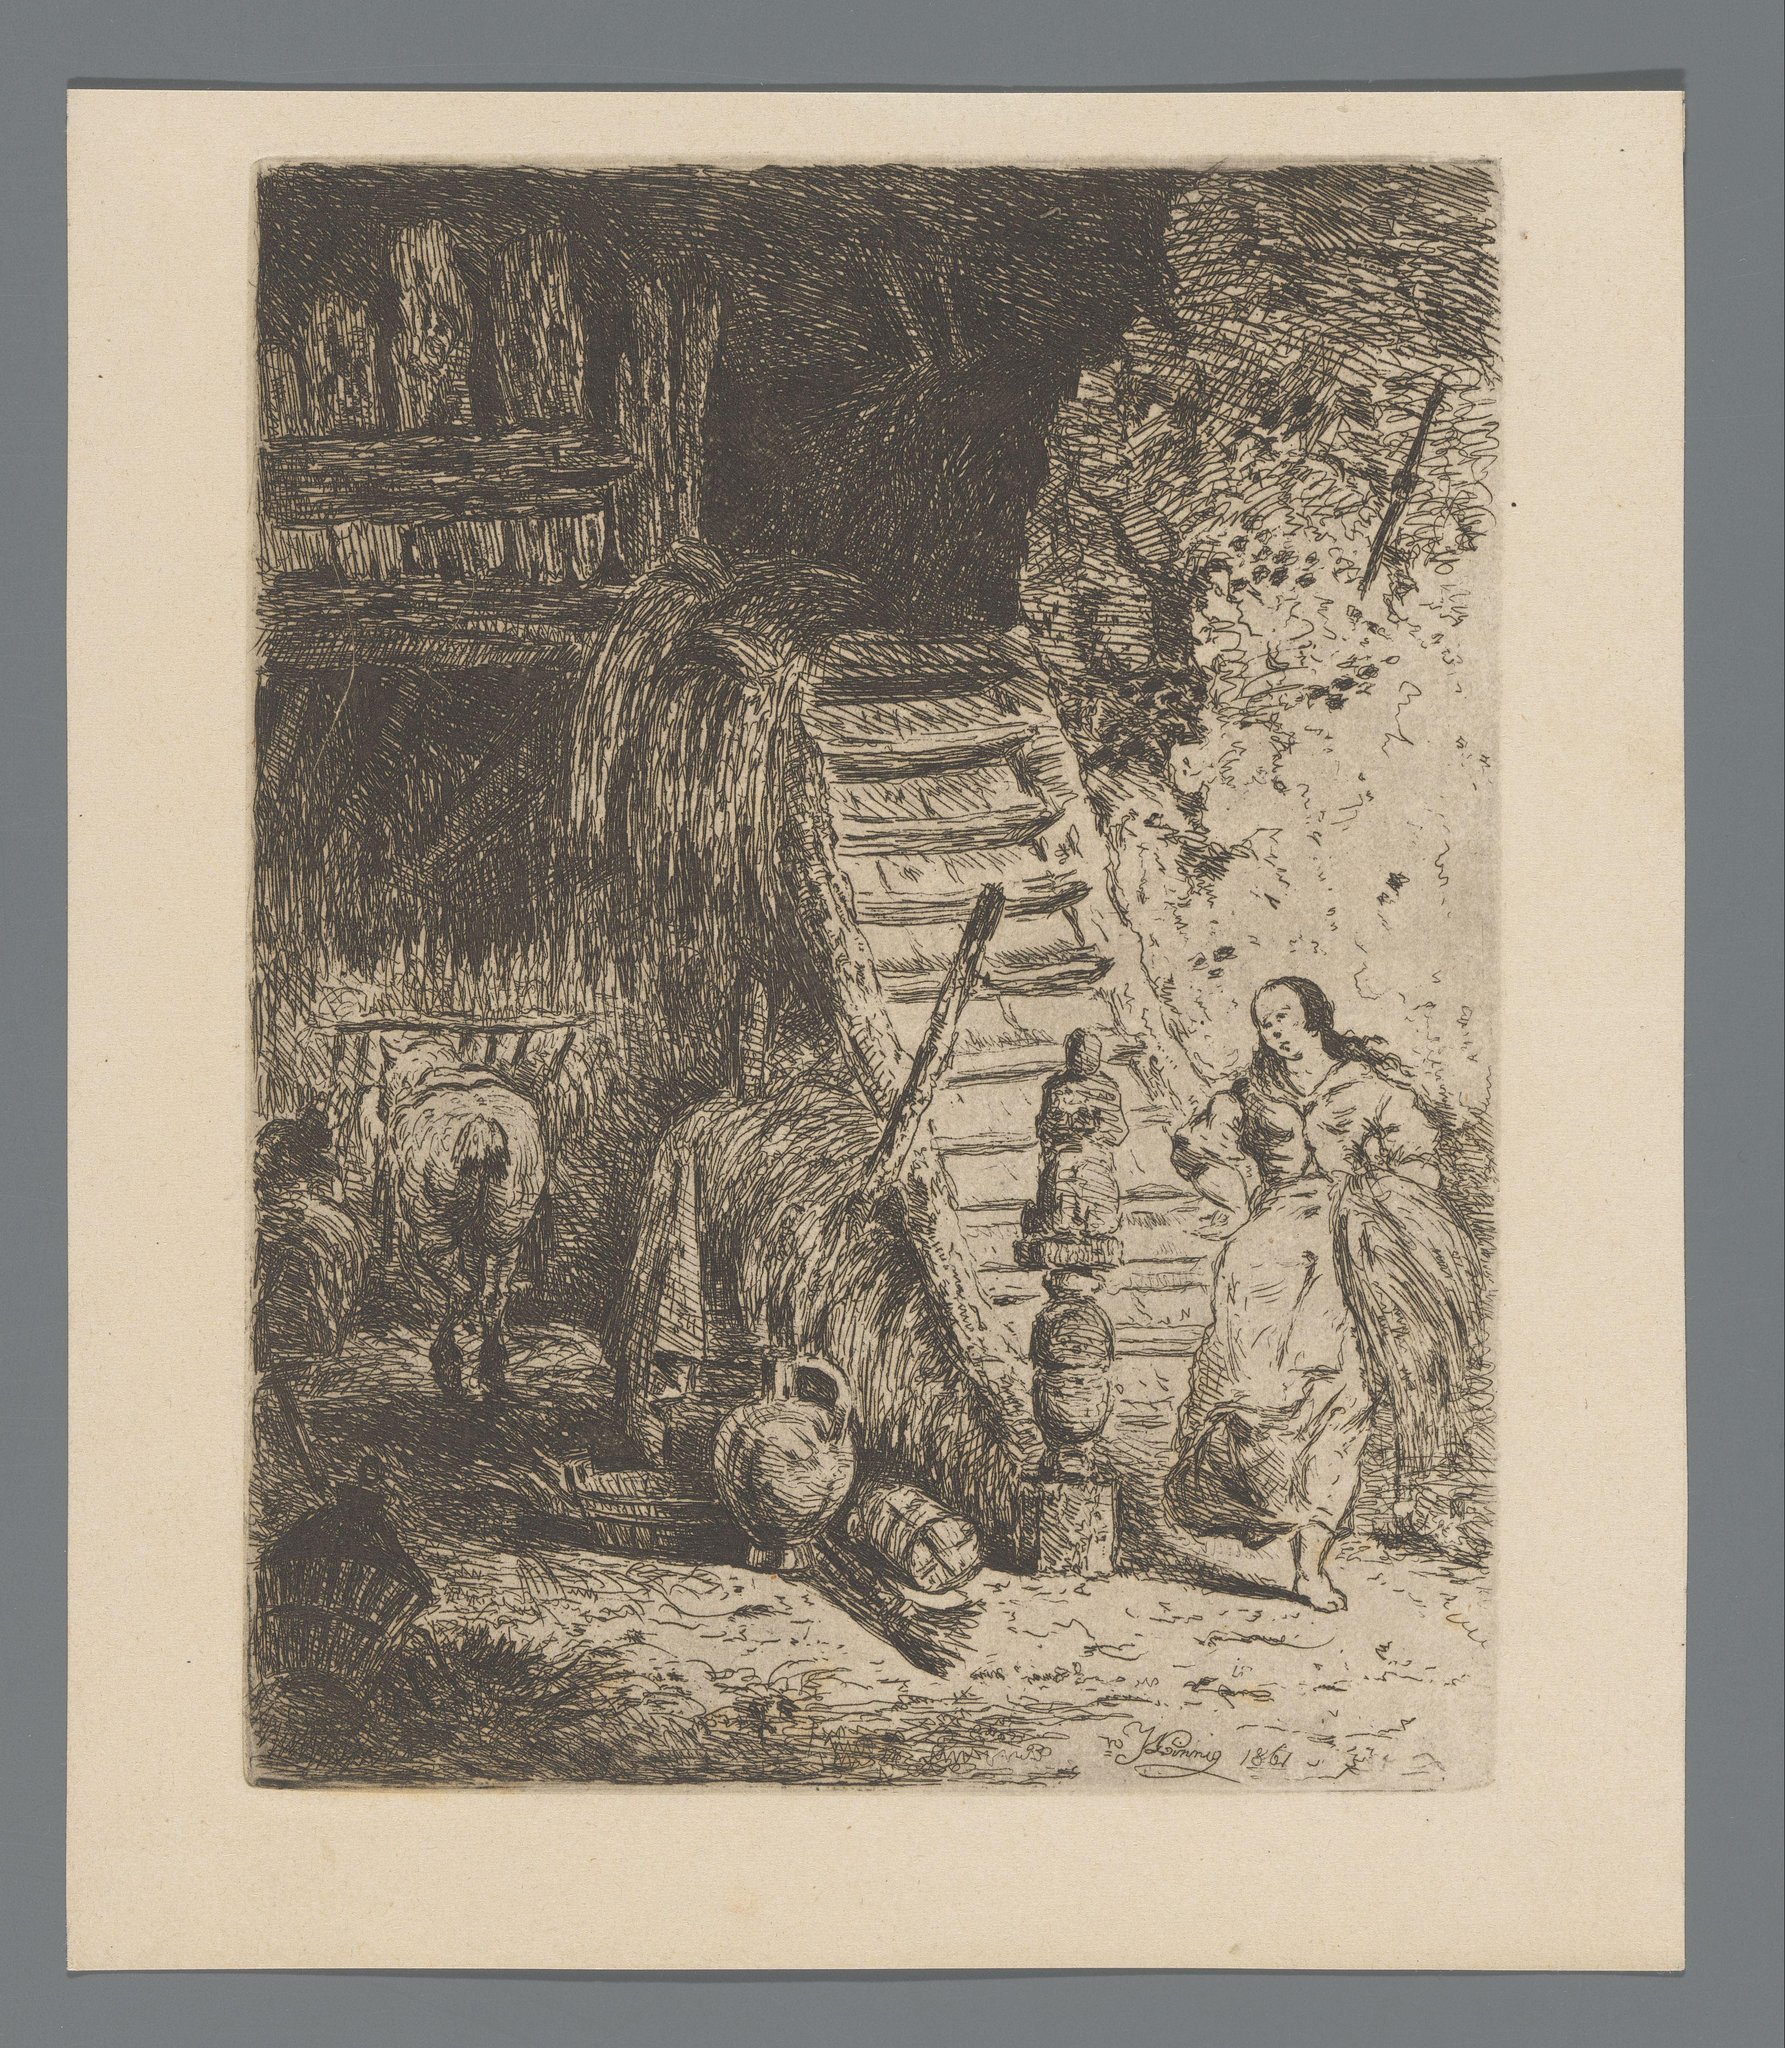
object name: print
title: Boerin in een schuur komt de trap af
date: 1861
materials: paper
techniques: etching, intaglio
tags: barn, farmers - aa - female farmer, farmer's wife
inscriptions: collector's mark: Lugt 1485, collector's mark: Lugt 2228